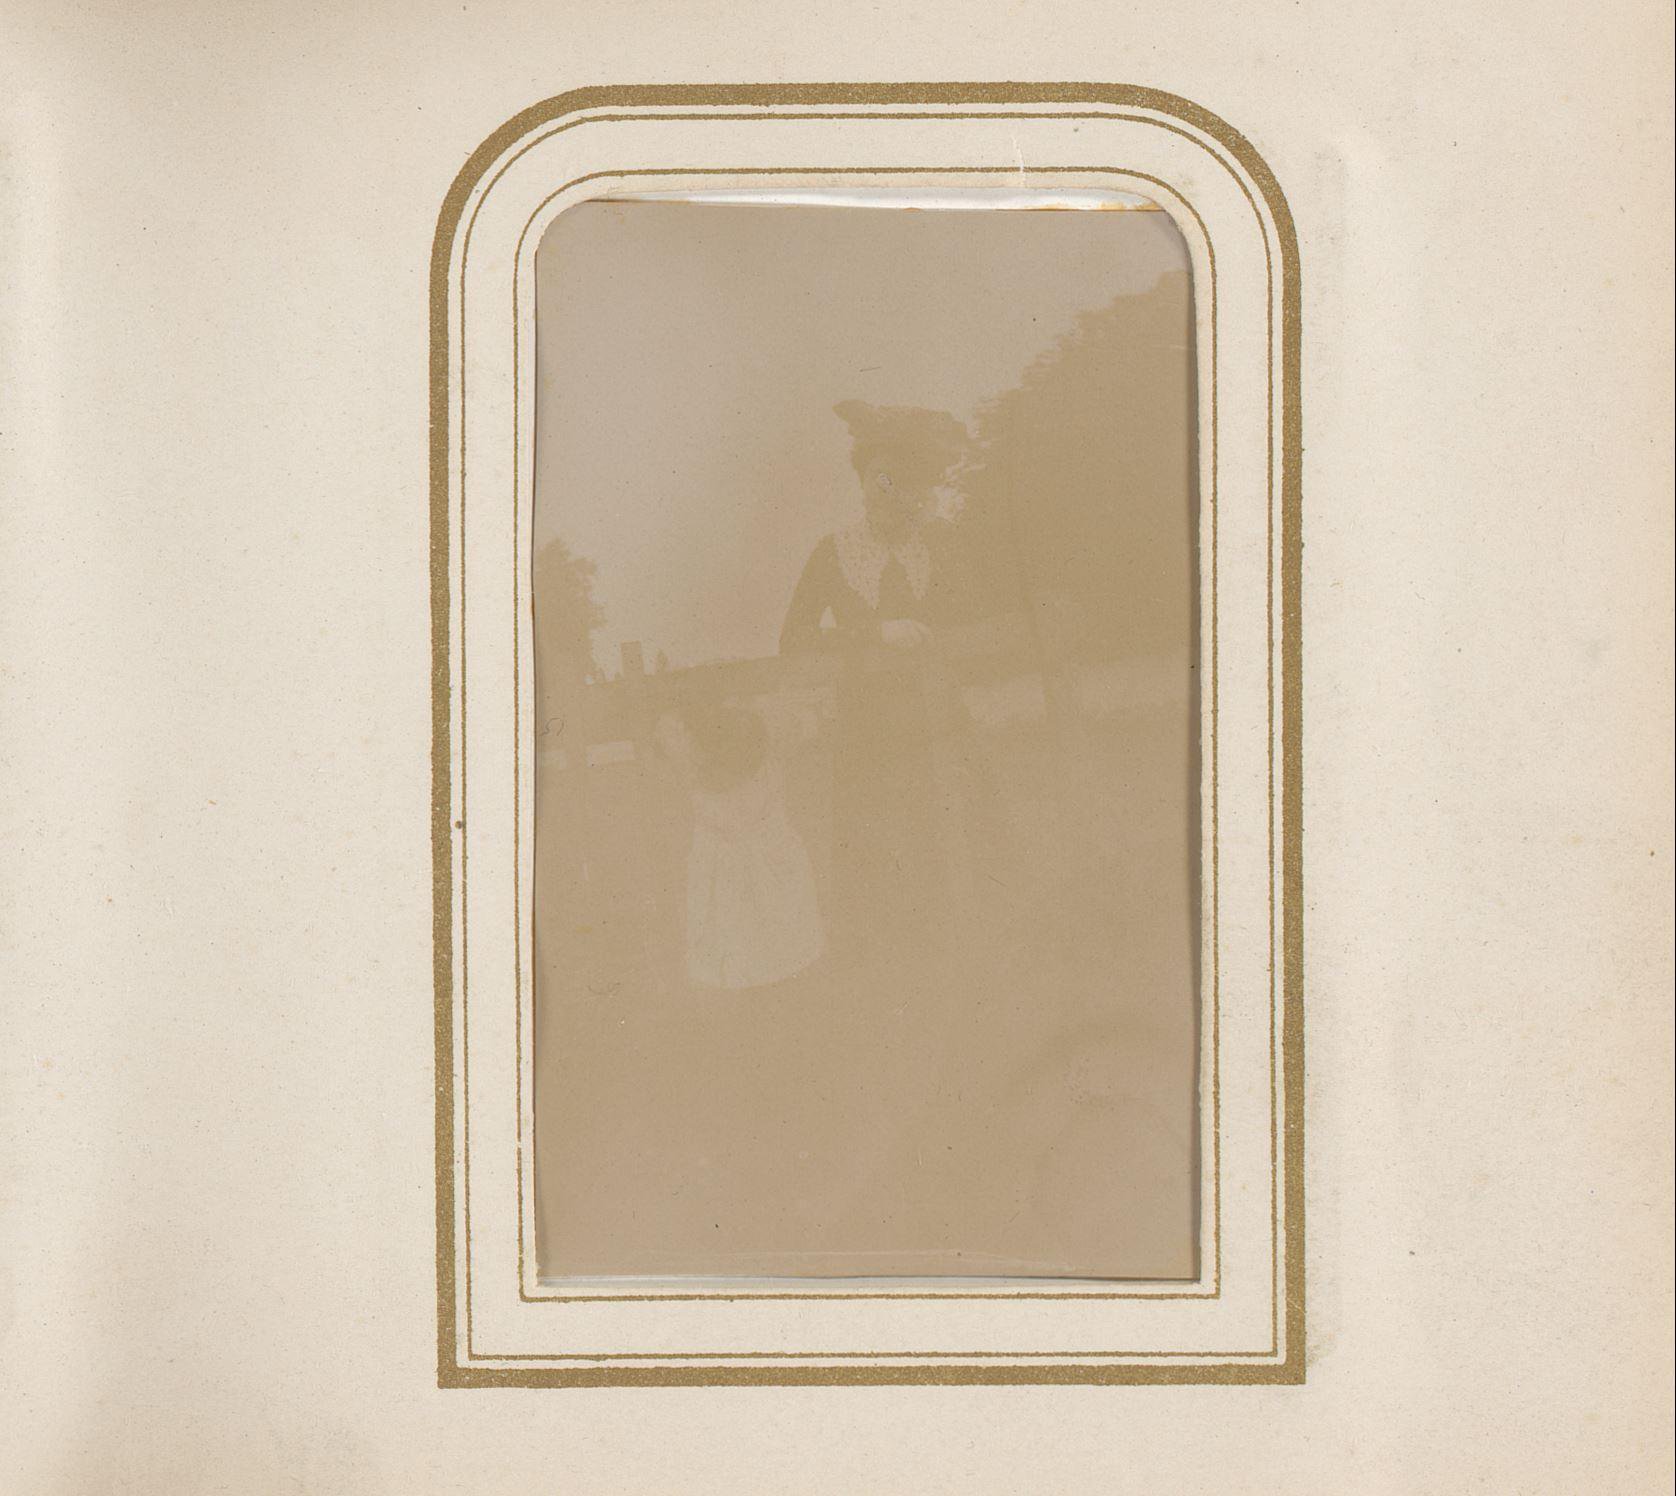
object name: album leaf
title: Portret van een vrouw met parasol, staand op een trap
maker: Anonymous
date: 1880-1920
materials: cardboard, photographic support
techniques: gelatin silver print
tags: adult woman, flight of steps, historical persons, standing figure - aa - female human figure, parasol, sunshade